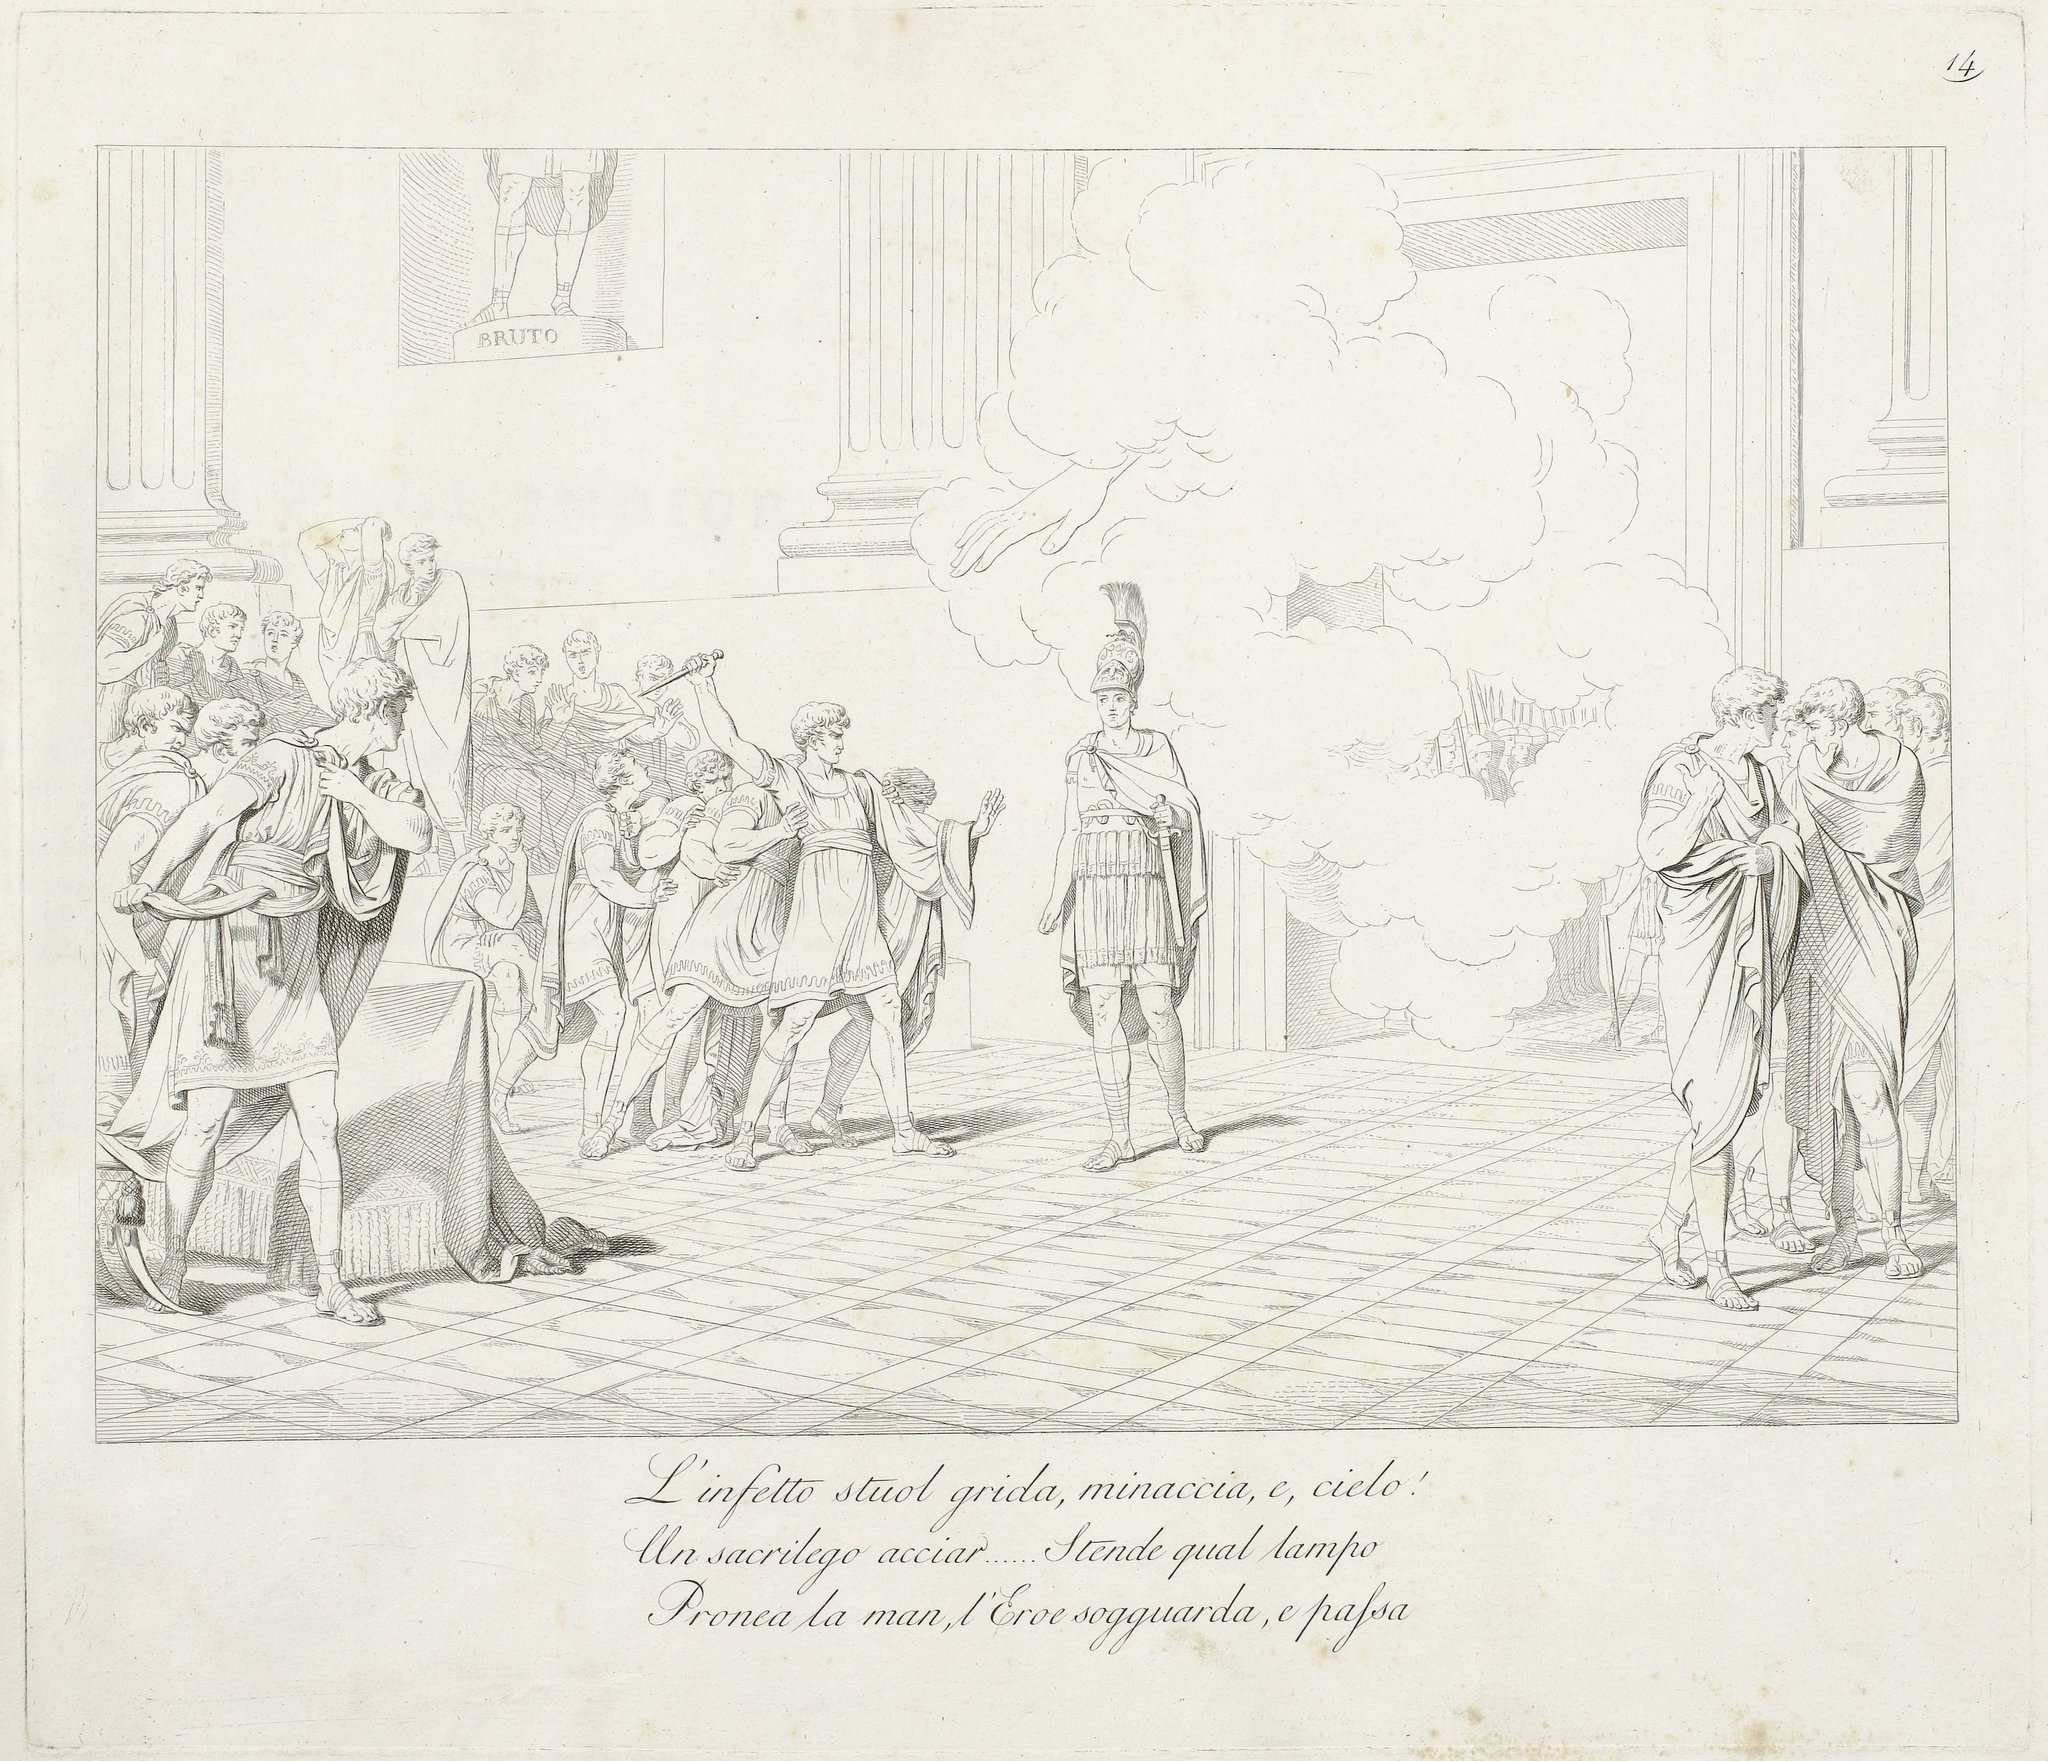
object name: album leaf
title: La pronea del Cesarotti delineata ed incisa dal Matteini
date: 1808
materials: paper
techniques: etching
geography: italy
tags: napoleon i (emperor of the french), temple, shrine ~ roman religion, the soldier; the soldier's life, ruler, sovereign, attempt, political murder, interior ~ representation of a building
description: Onder de voorstelling een versregel in het Italiaans. Prent maakt deel uit van een album.